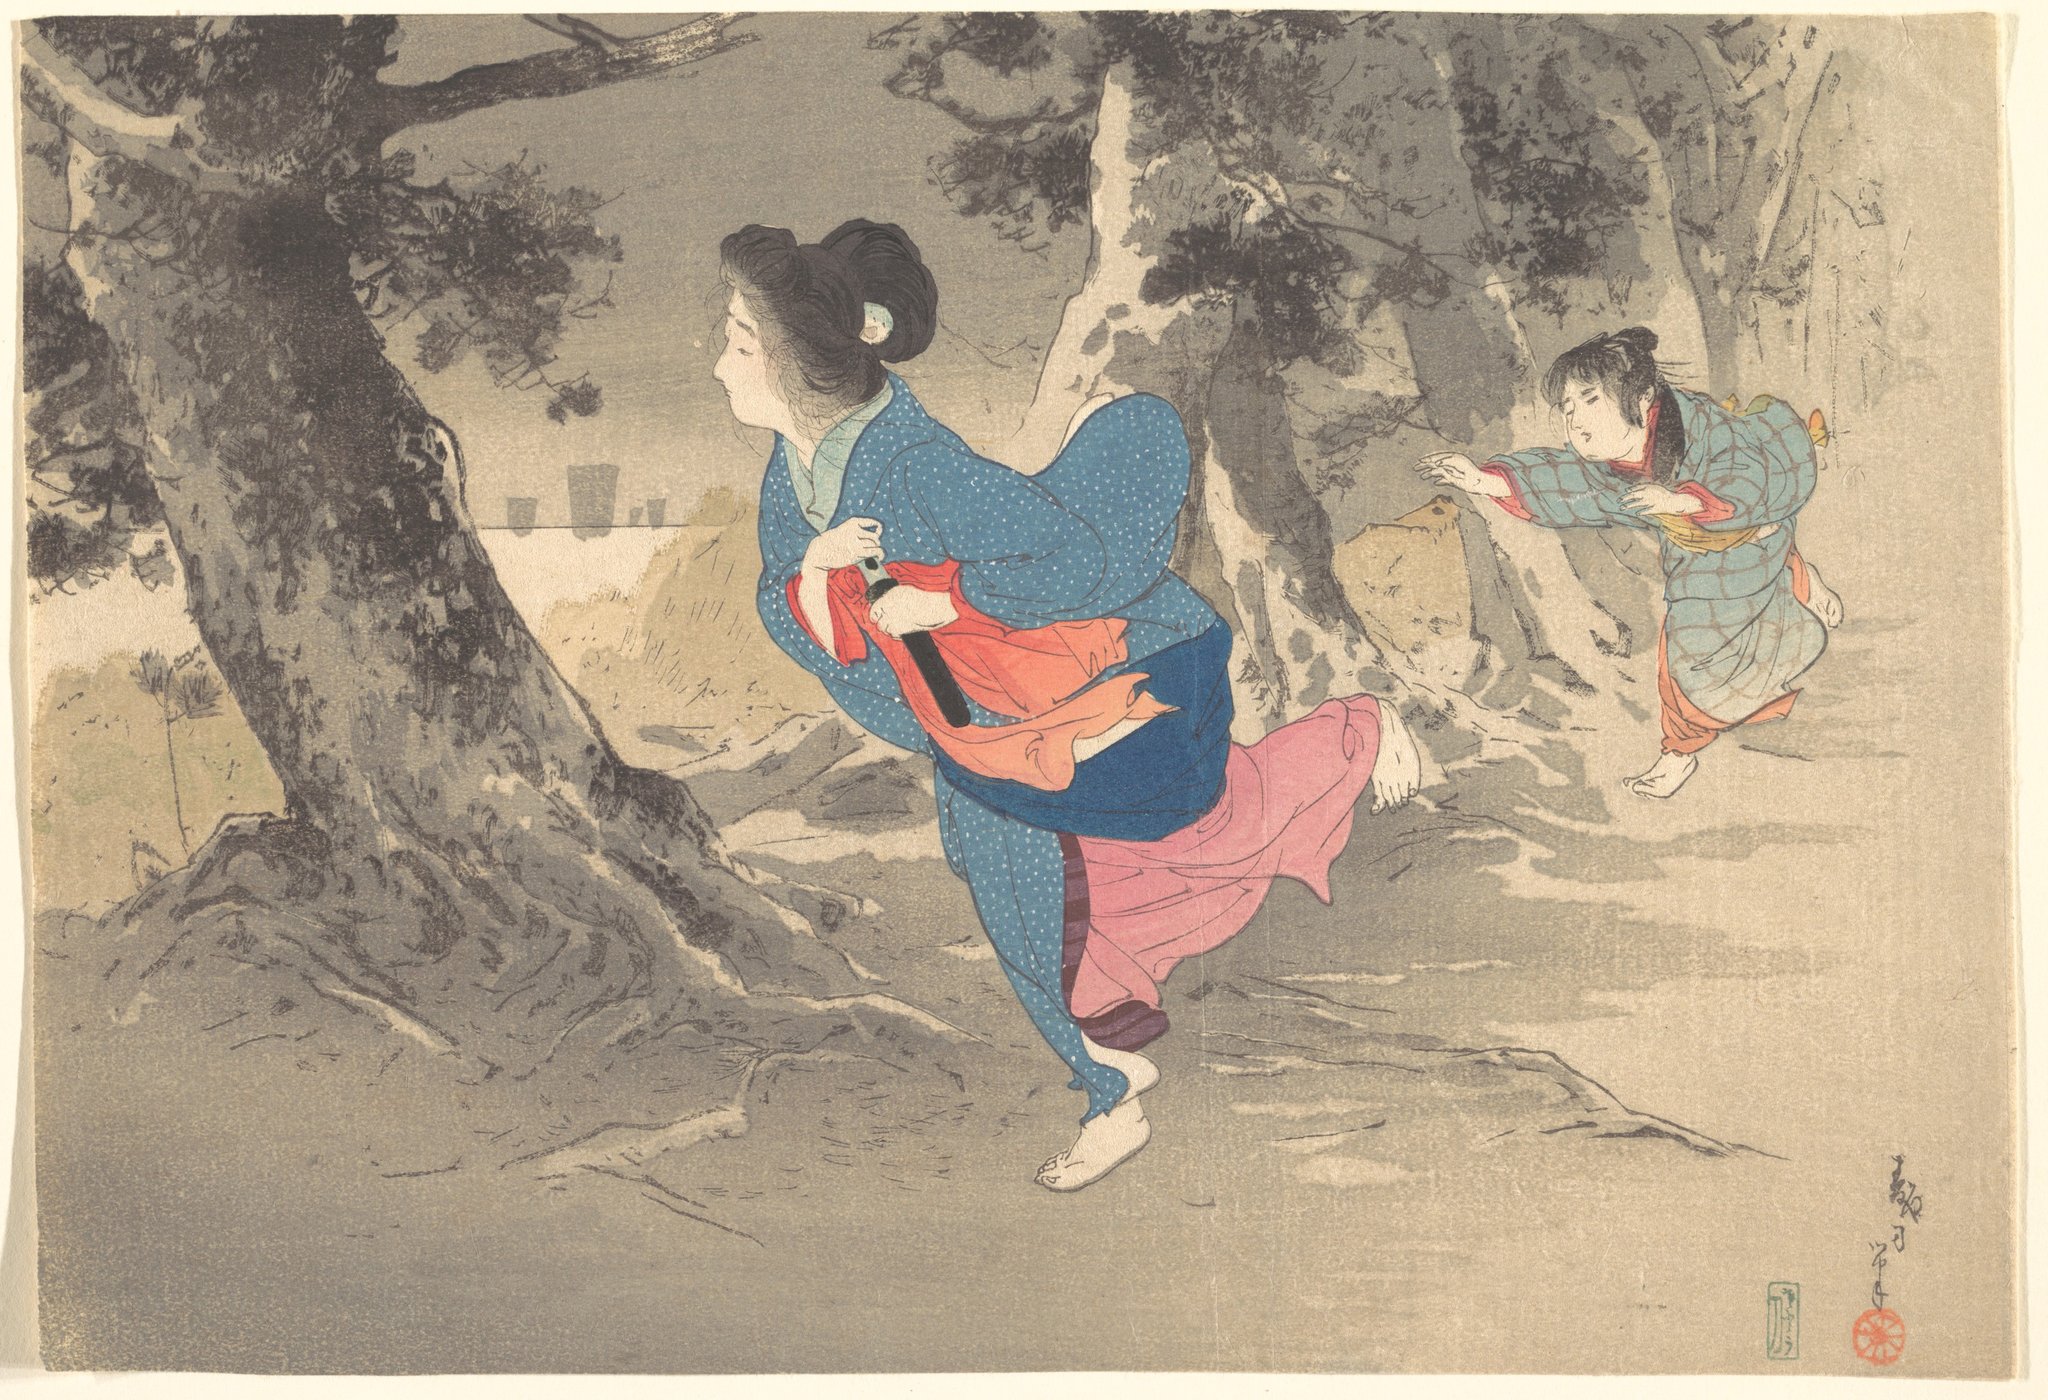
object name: print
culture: japanese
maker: unidentified artist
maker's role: artist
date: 1908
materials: ink, paper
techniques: woodblock print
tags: women,running,trees